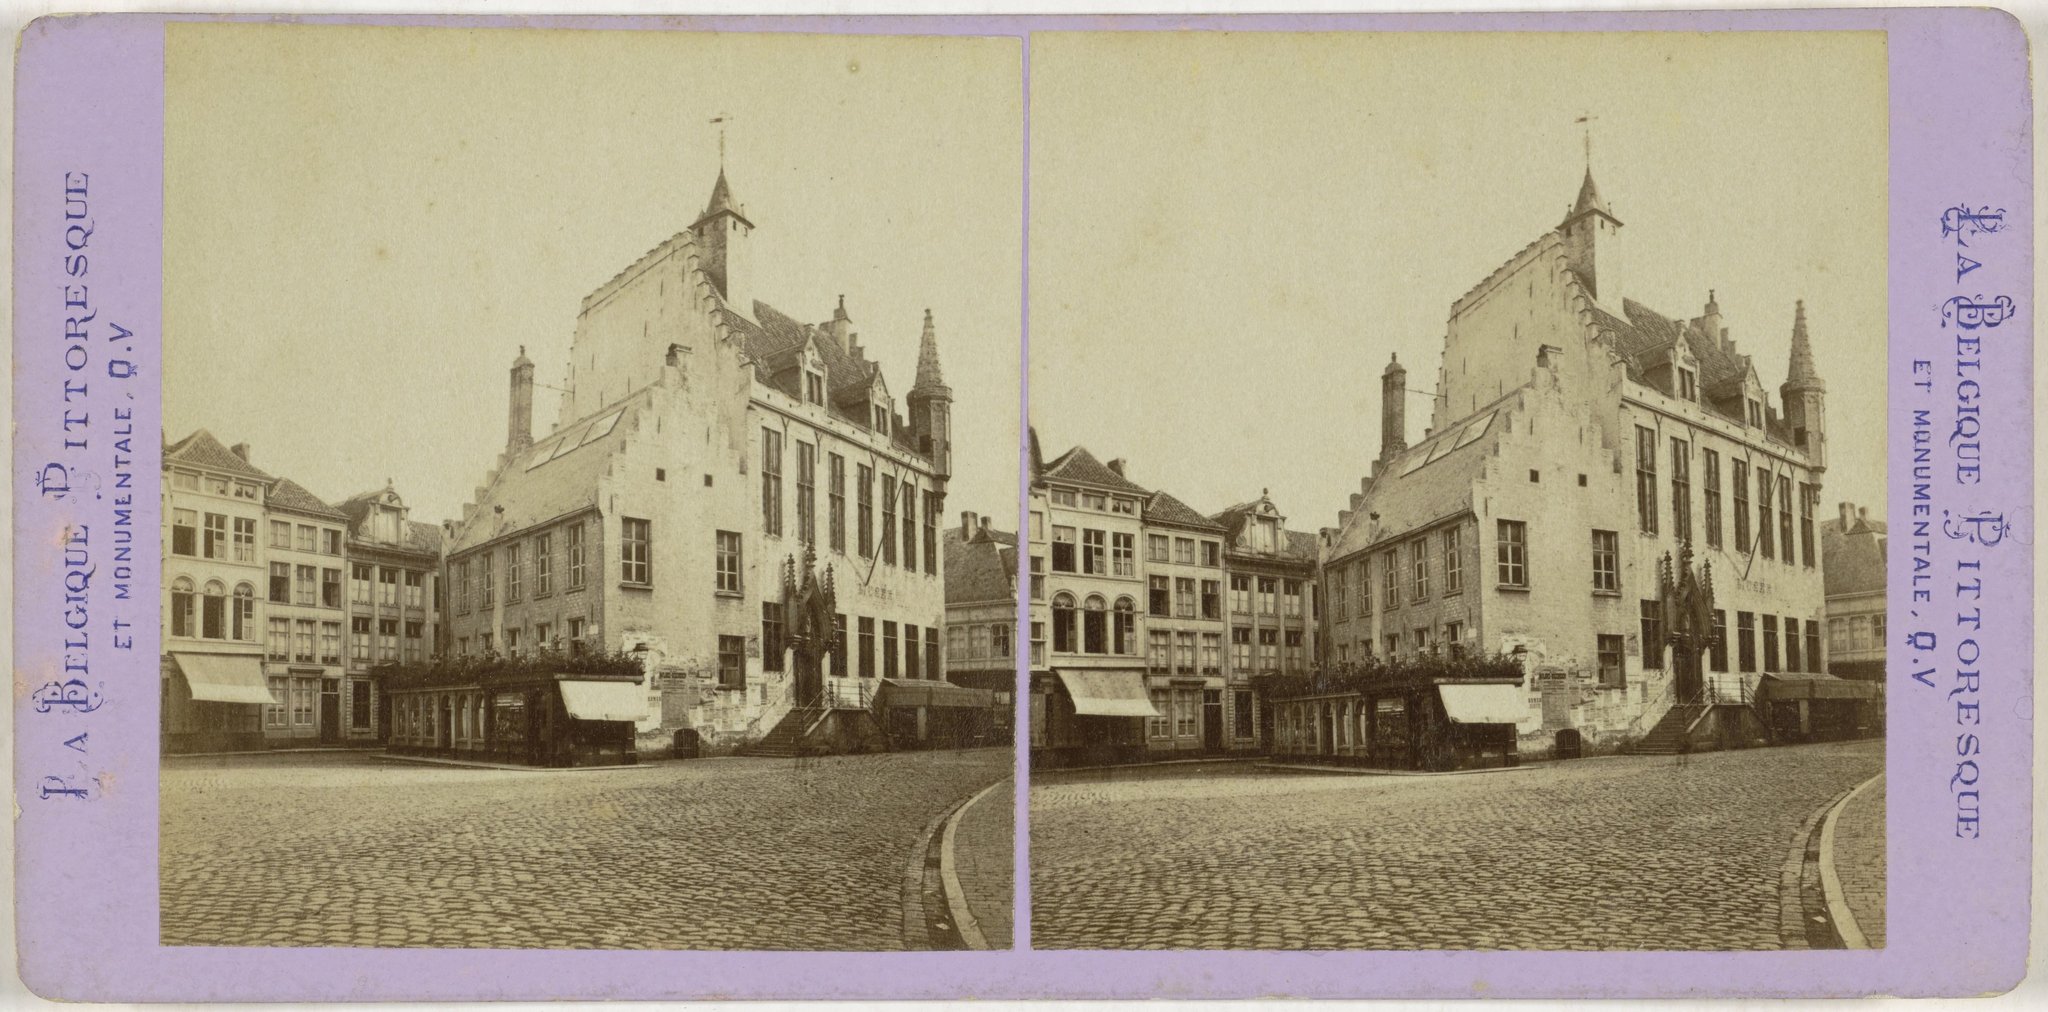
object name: stereograph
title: Gezicht op het Schepenhuis in Mechelen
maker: jules hippolyte quéval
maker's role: publisher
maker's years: 1824-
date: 1866-1870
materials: cardboard, paper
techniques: albumen print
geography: mechelen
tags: square, place, circus, etc., urban housing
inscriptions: number: ‘No 1637’